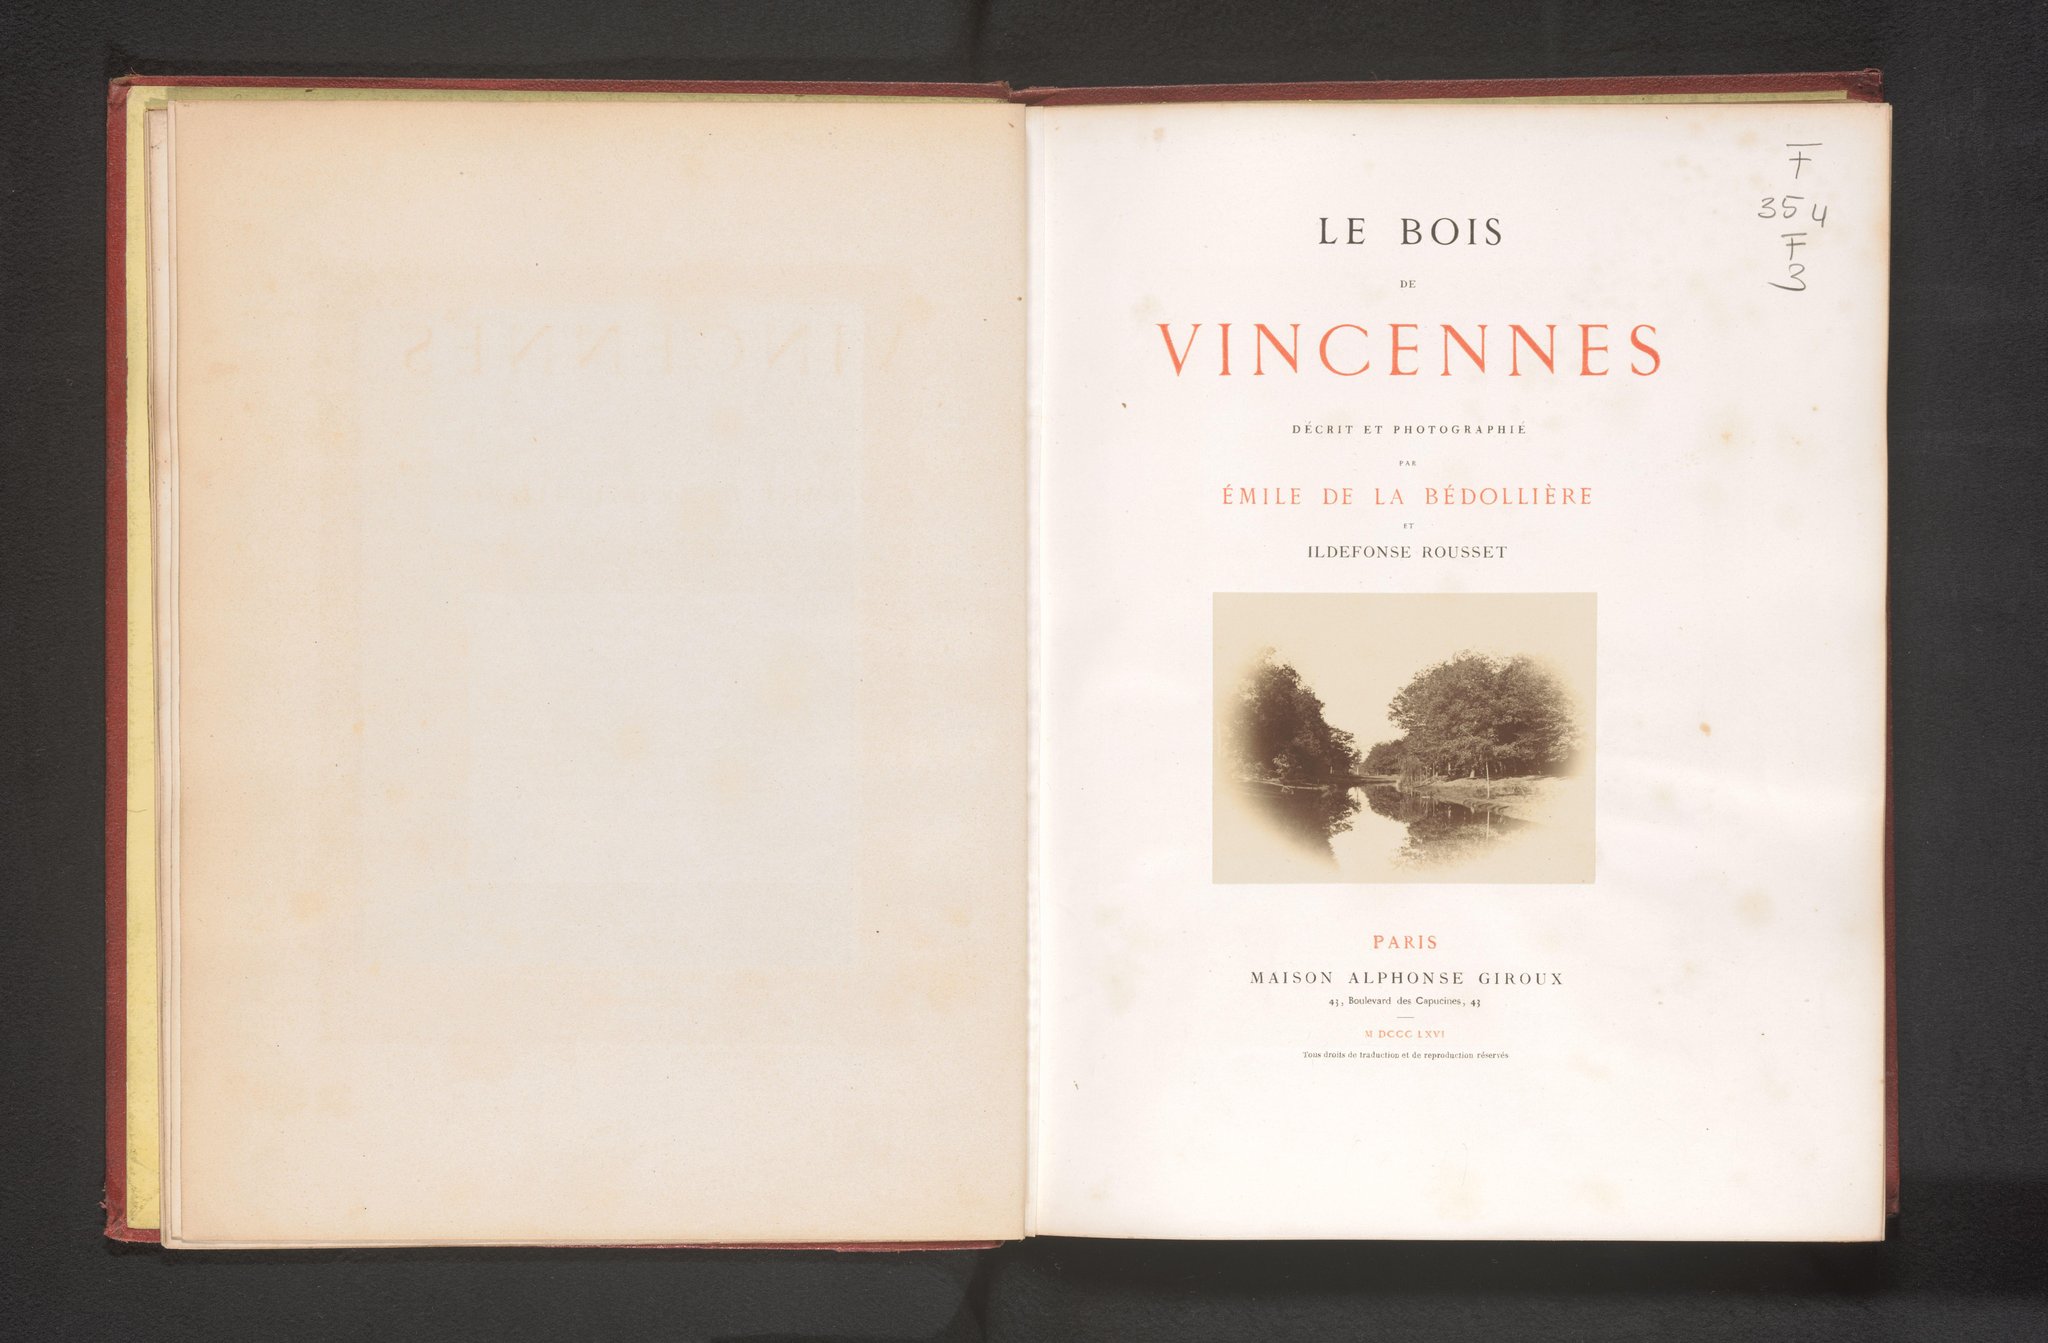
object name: book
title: Le bois de Vincennes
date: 1866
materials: cardboard, linen, paper, photographic support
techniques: albumen print, lithograph, printing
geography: paris